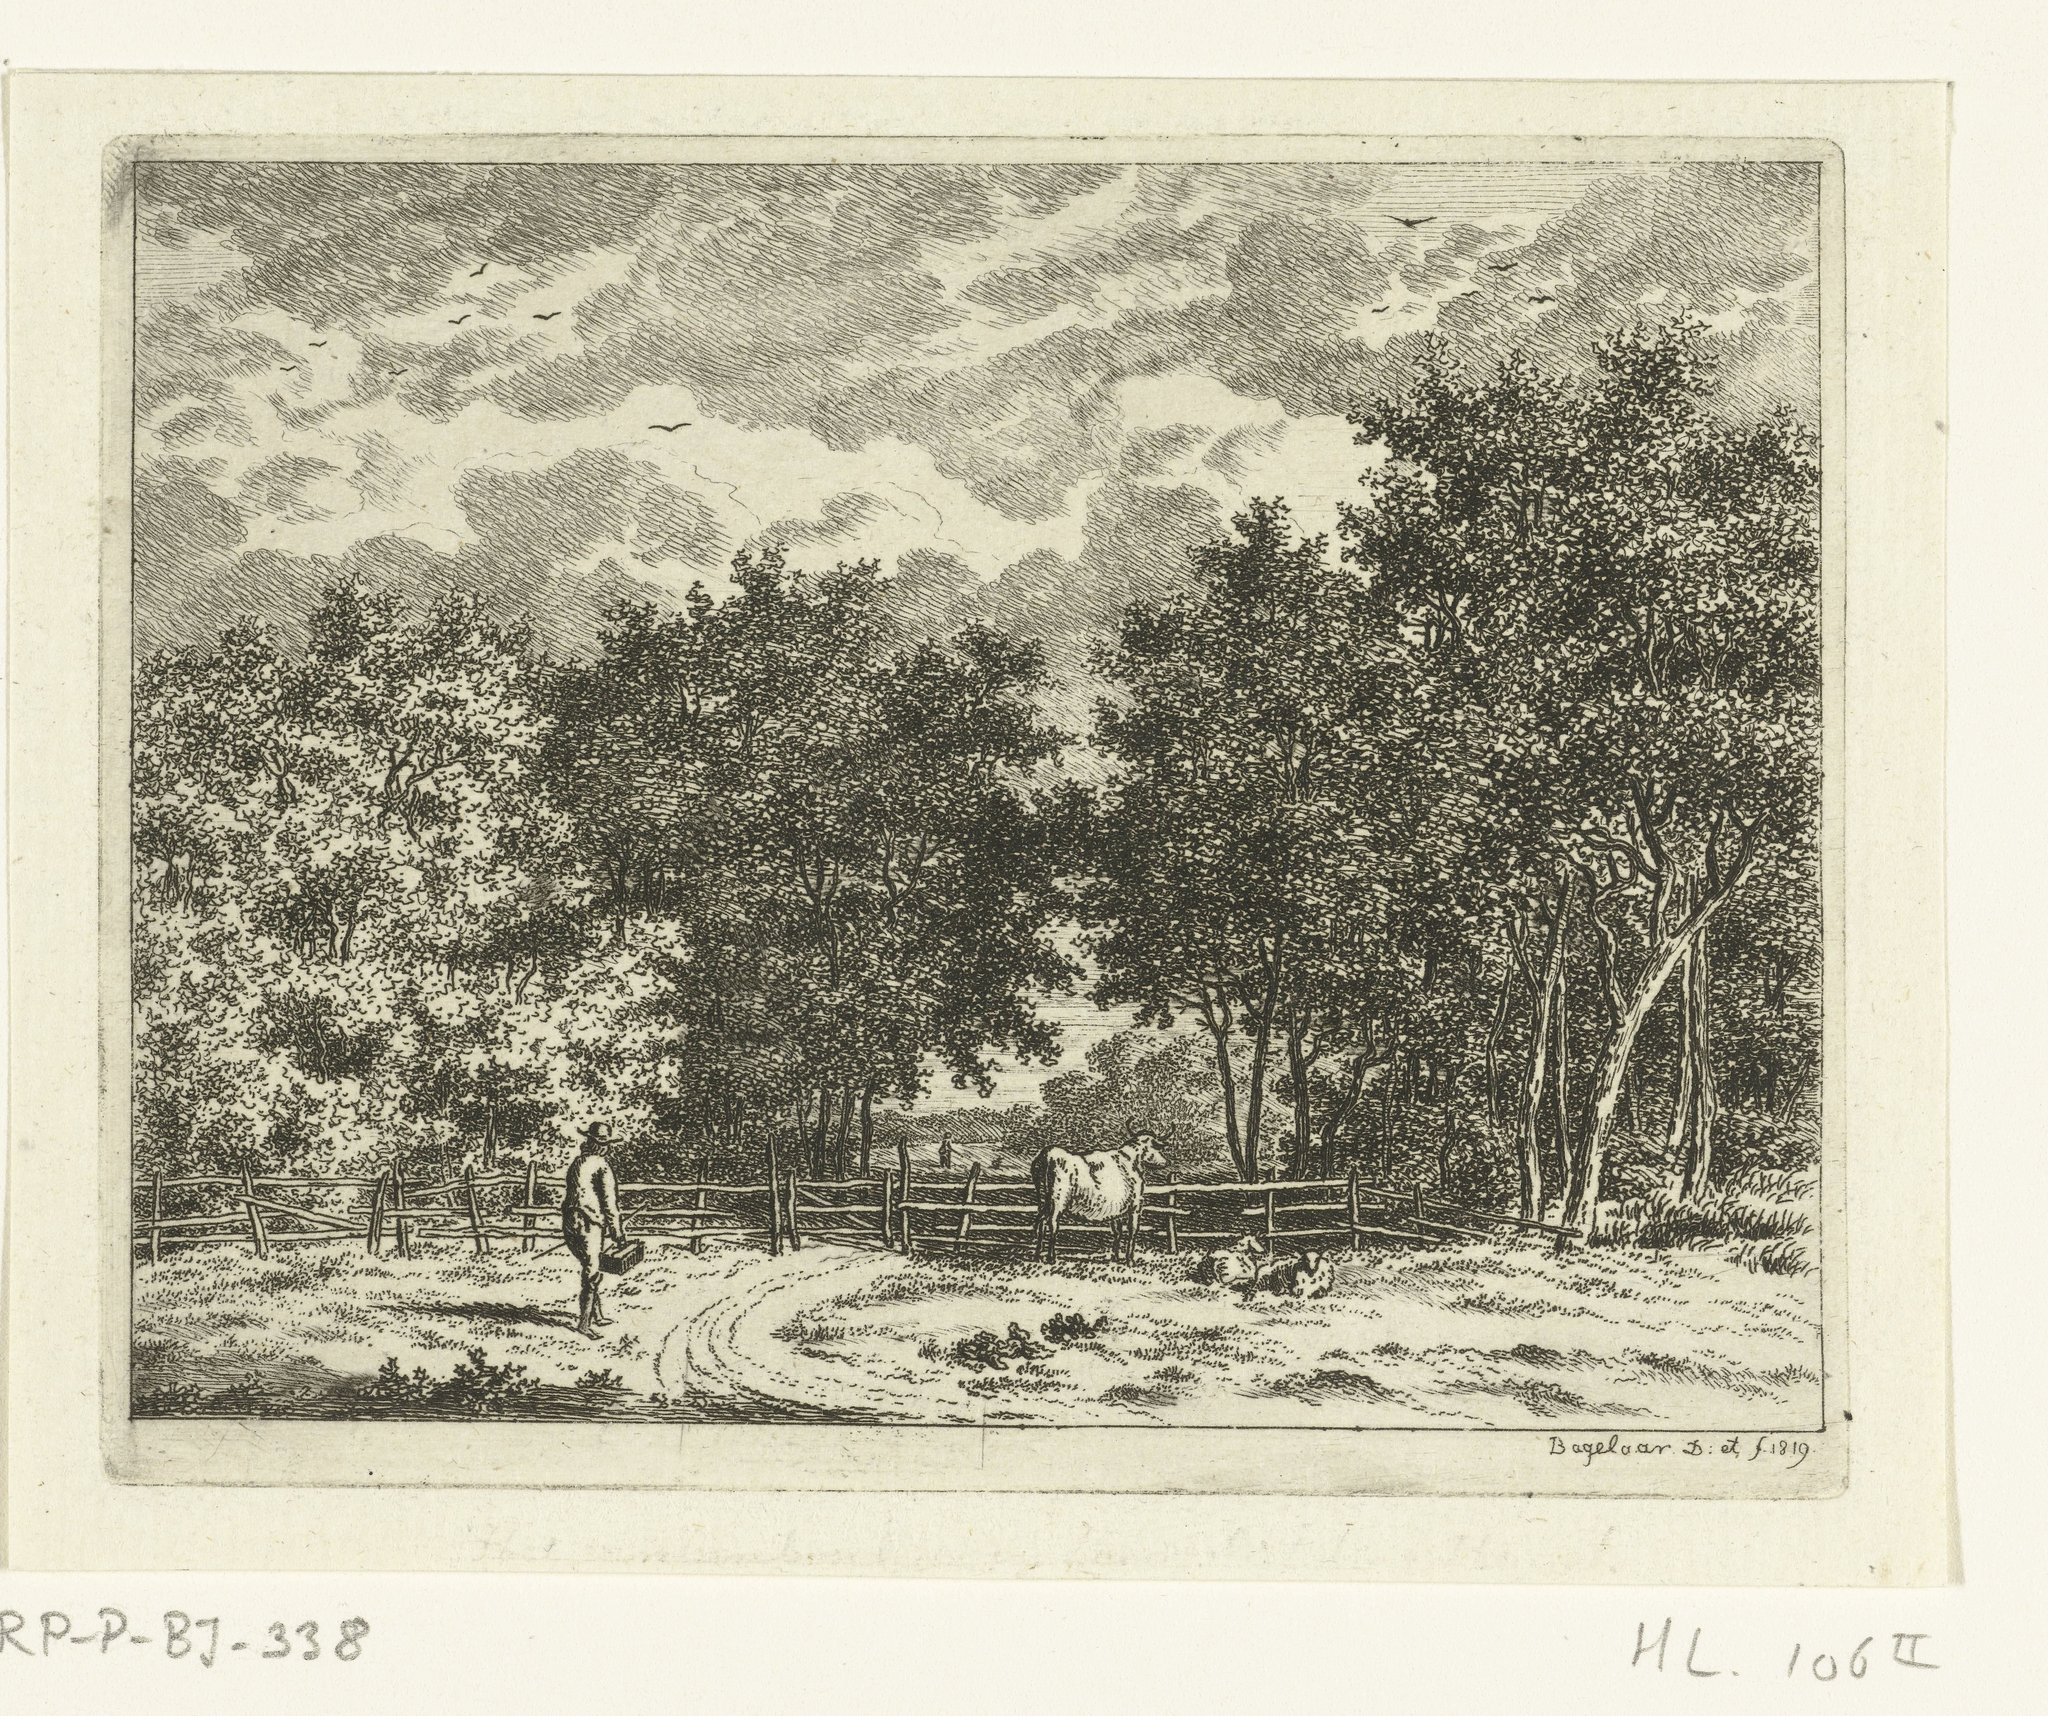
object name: print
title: Weiland met een koe en twee schapen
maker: ernst willem jan bagelaar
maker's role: draughtsman, print maker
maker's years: 1775-1837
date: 1819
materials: paper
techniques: drypoint, etching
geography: netherlands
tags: cow, meadow, pasture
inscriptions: collector's mark: Lugt 2228